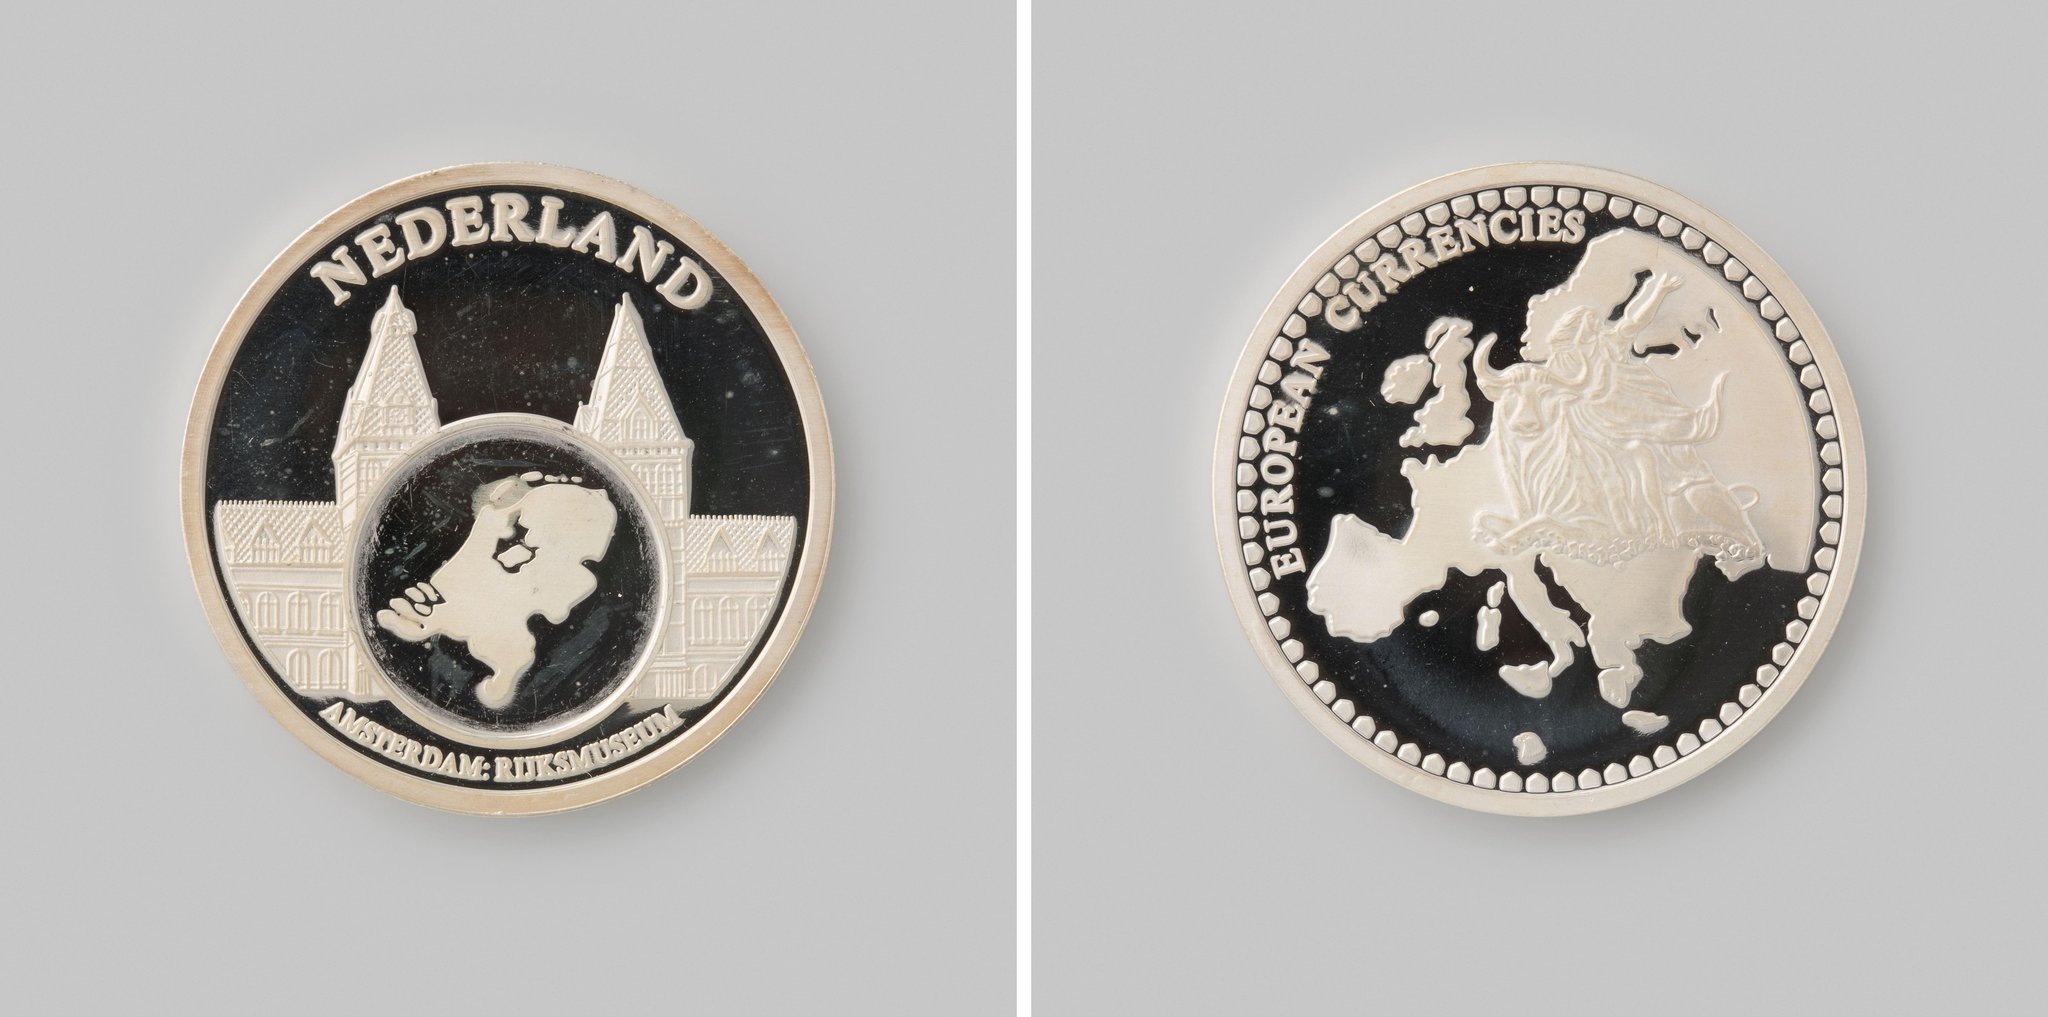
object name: medal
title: Amsterdam: Rijksmuseum, European Currencies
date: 2001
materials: copper, plastic, silver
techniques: silvering, striking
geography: munich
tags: rijksmuseum amsterdam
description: Verzilverde munt. Voorzijde: voorgevel Rijksmuseum, waarin verdiept kaart van Nederland, binnen omschrift ('Nederland / Amsterdam: Rijksmuseum'). Keerzijde: kaart van Europa springende stier waarop vrouw ('De roof van Europa'), met opschrift ('European Currencies'), binnen rand van schildjes.